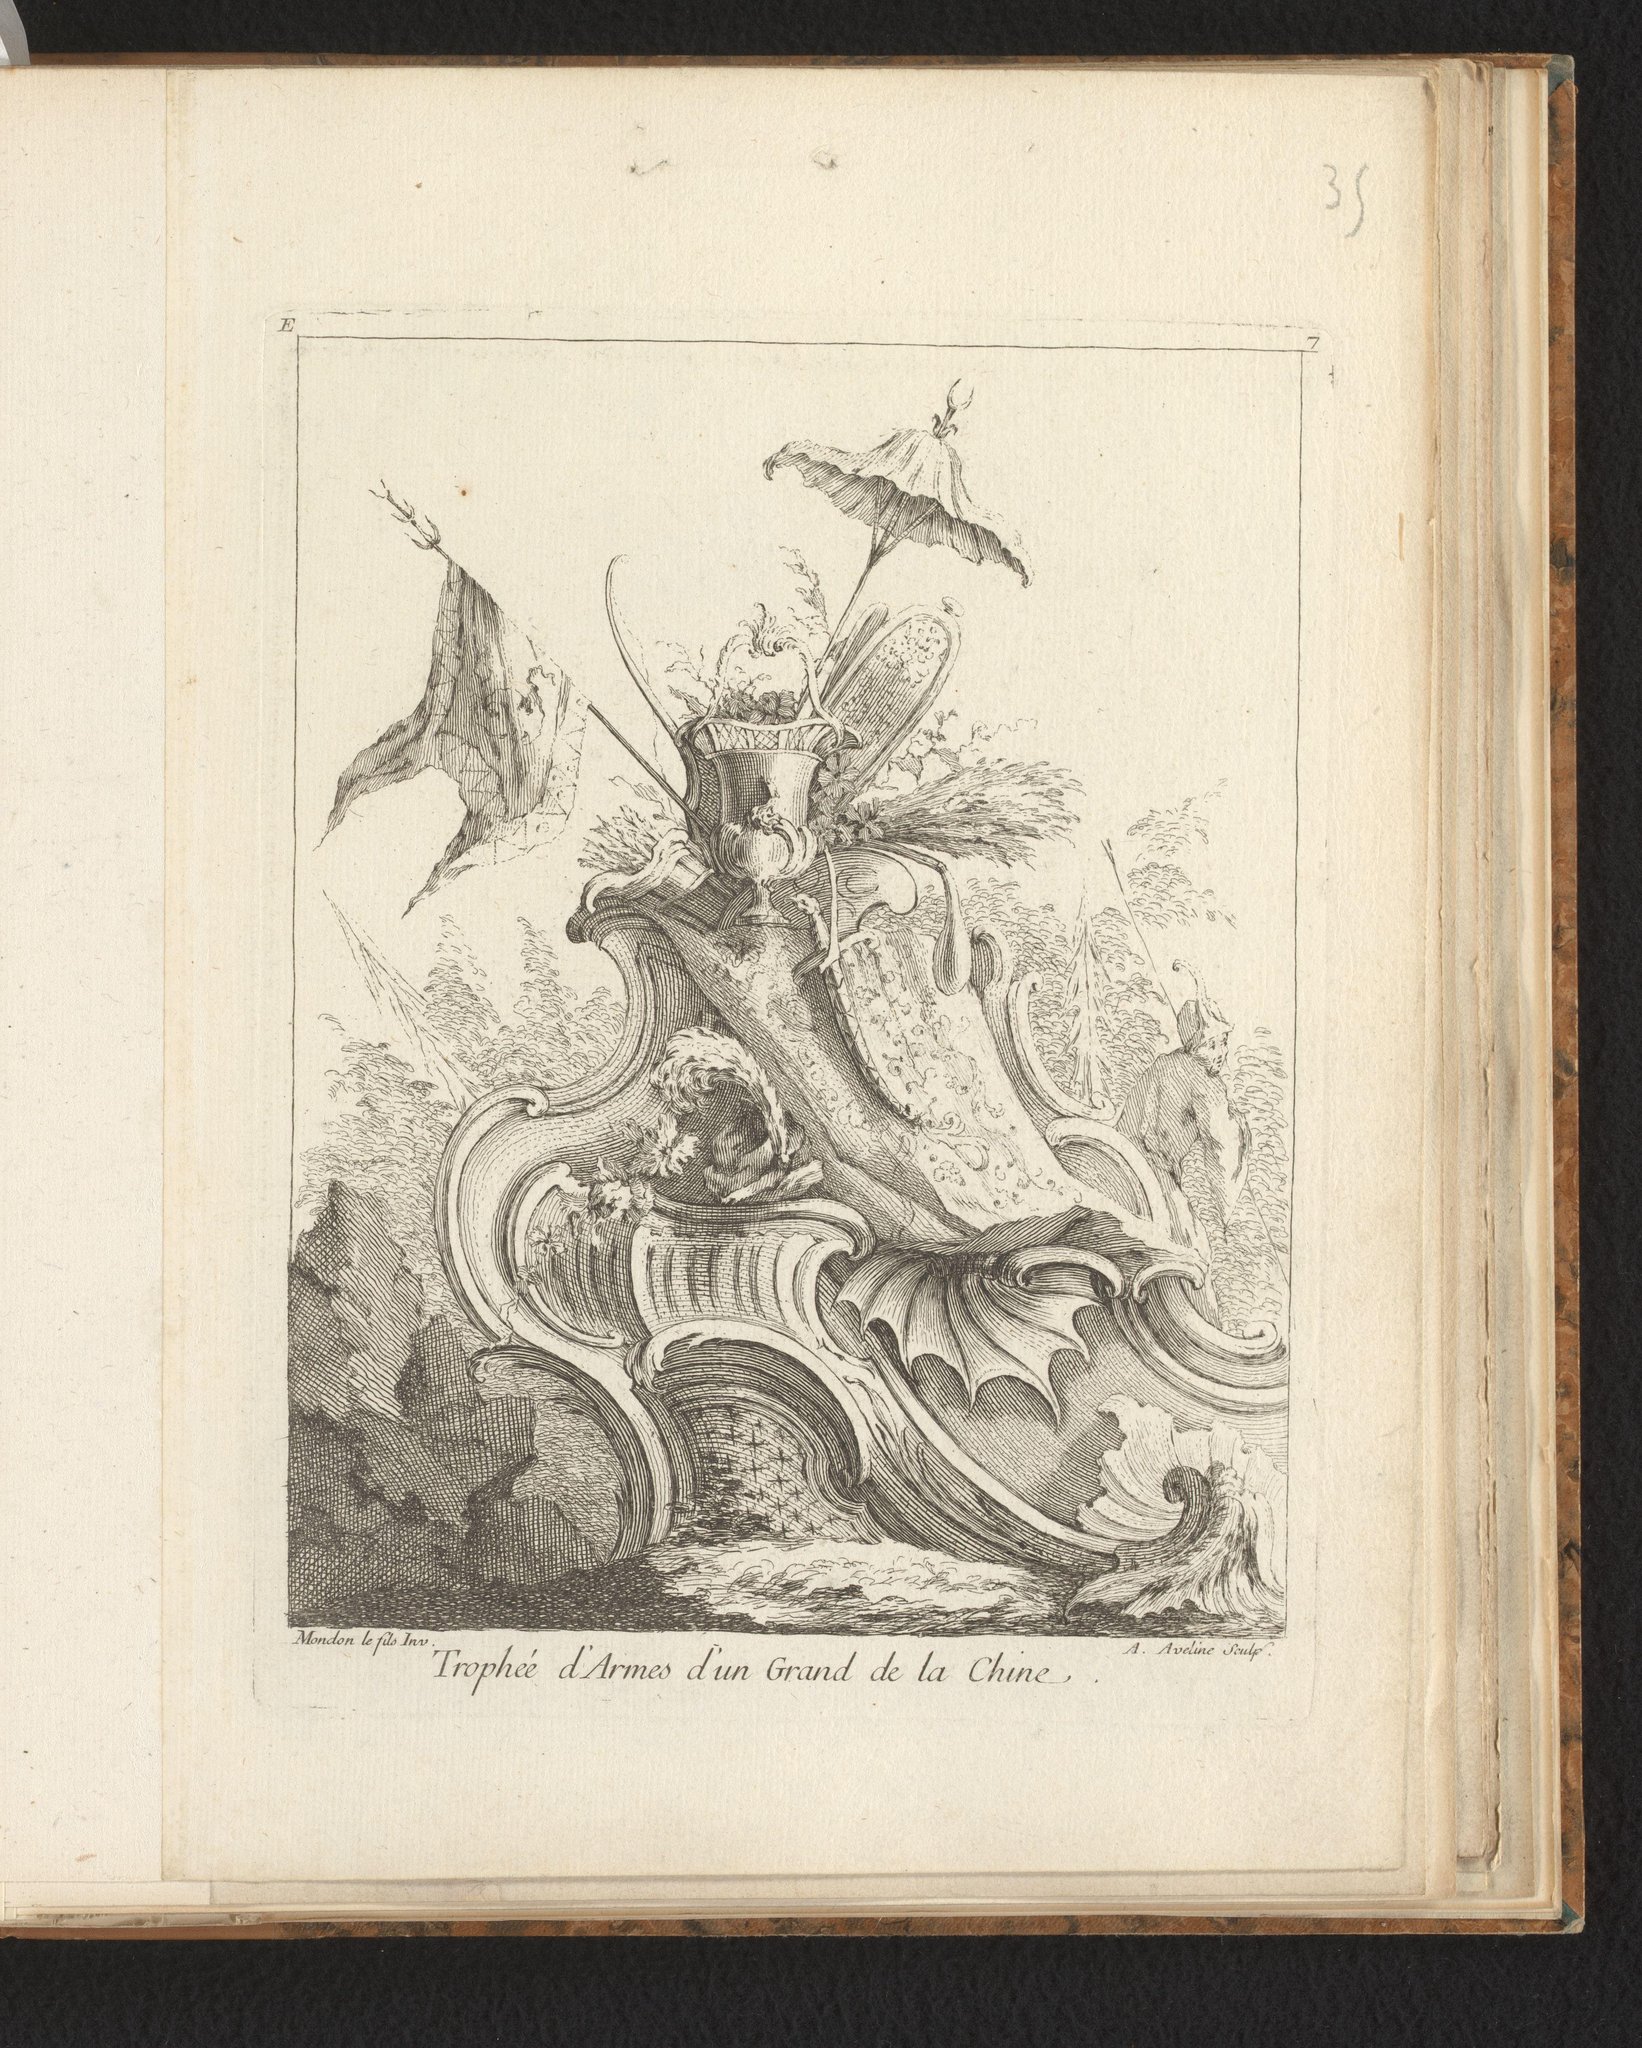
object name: print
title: Rocaille met oorlogstrofee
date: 1736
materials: paper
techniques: etching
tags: rocaille ornament, trophy ~ battle, war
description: Deze serie is linksboven genummerd met een letter E. Prent maakt deel uit van een album.